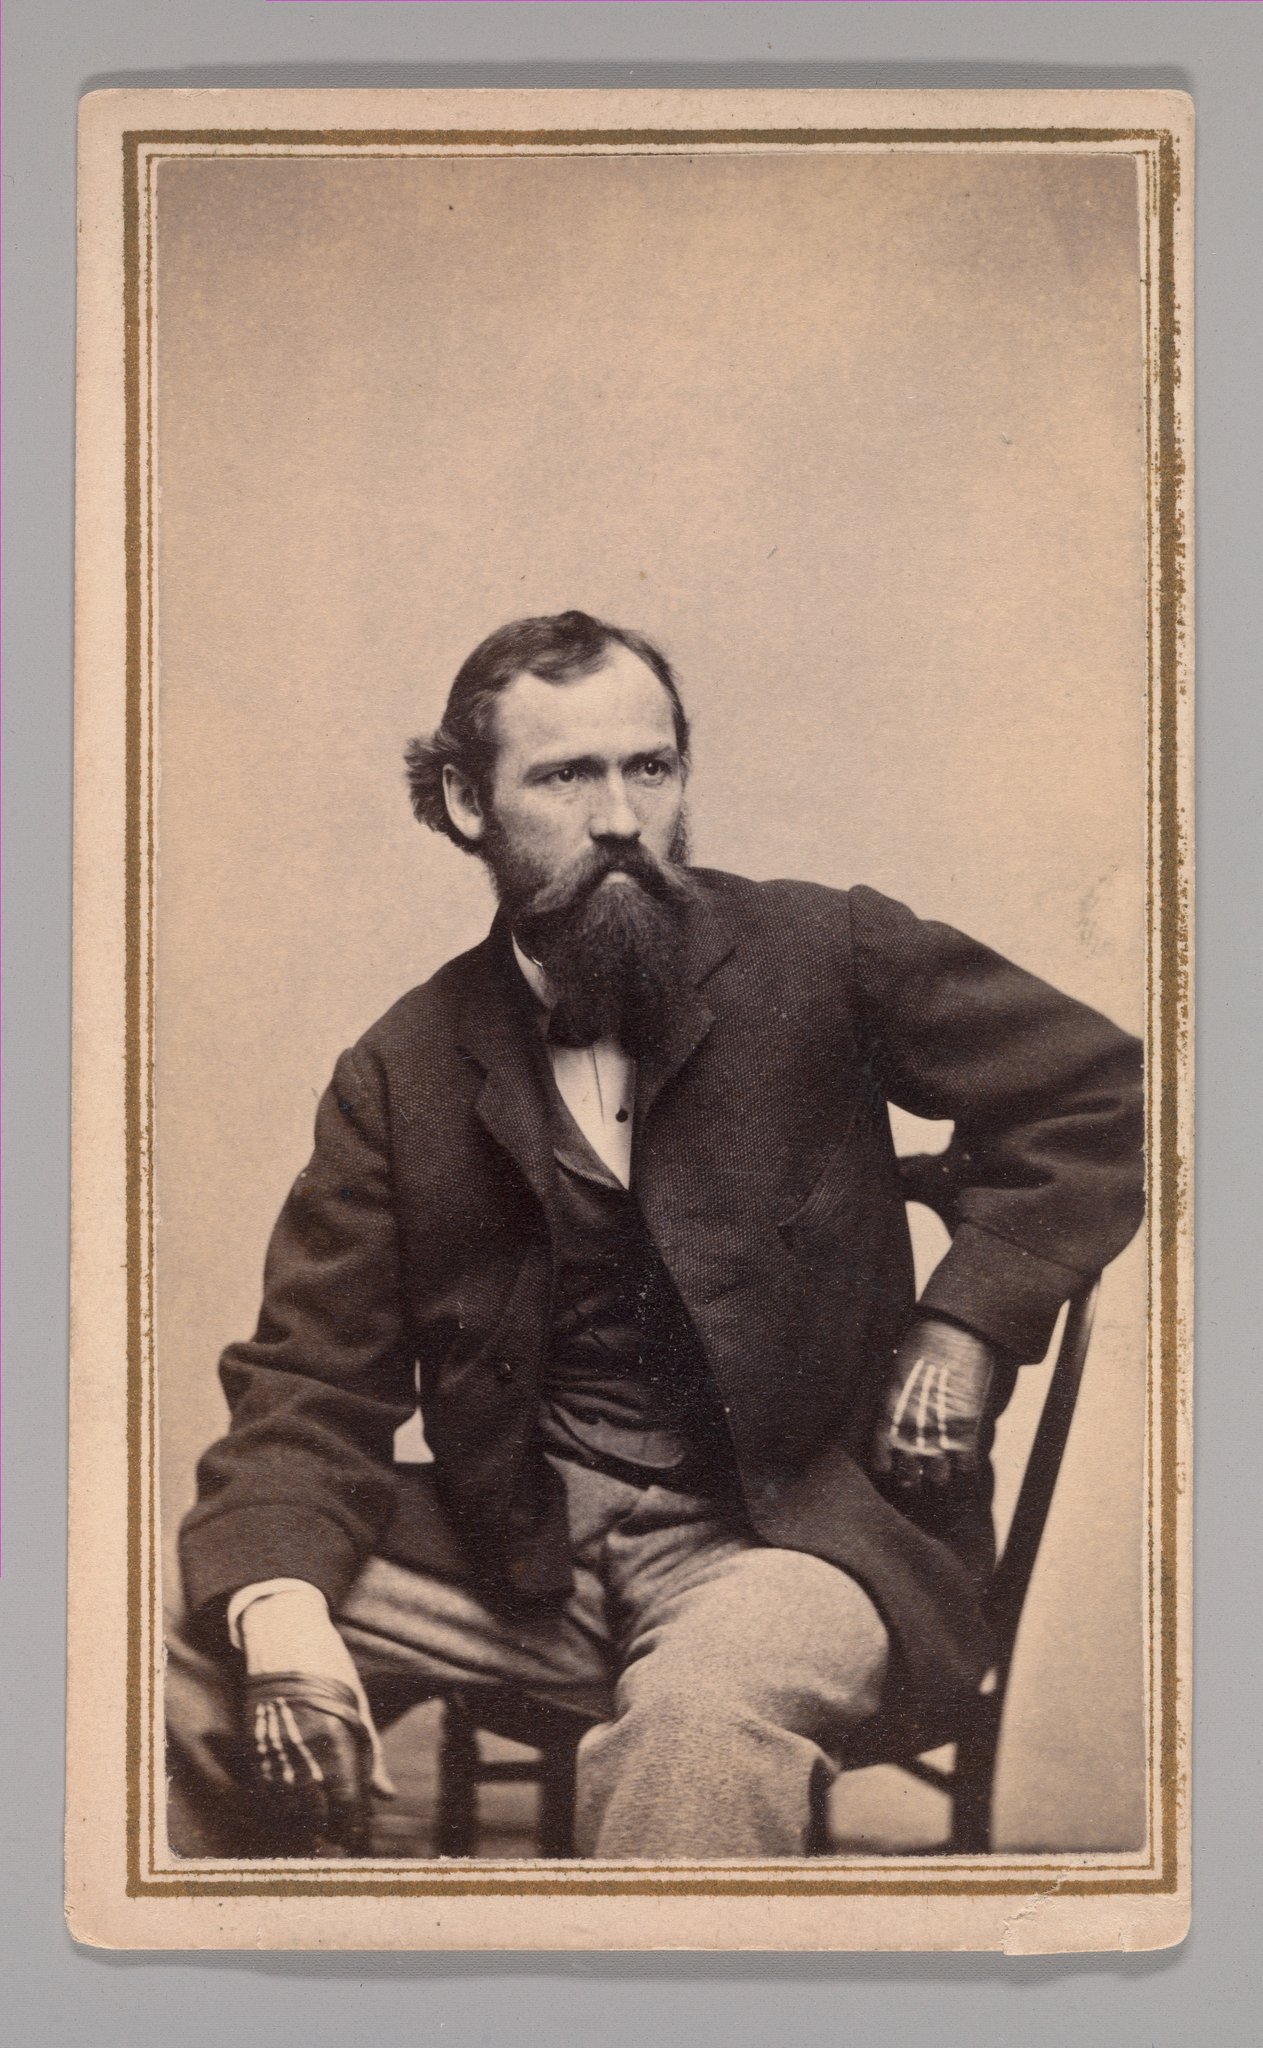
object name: carte de visite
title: [Unknown Subject]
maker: george gardner rockwood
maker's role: fotograaf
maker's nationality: american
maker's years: 1832-1911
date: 1860-1869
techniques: albumen silver print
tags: men,portraits